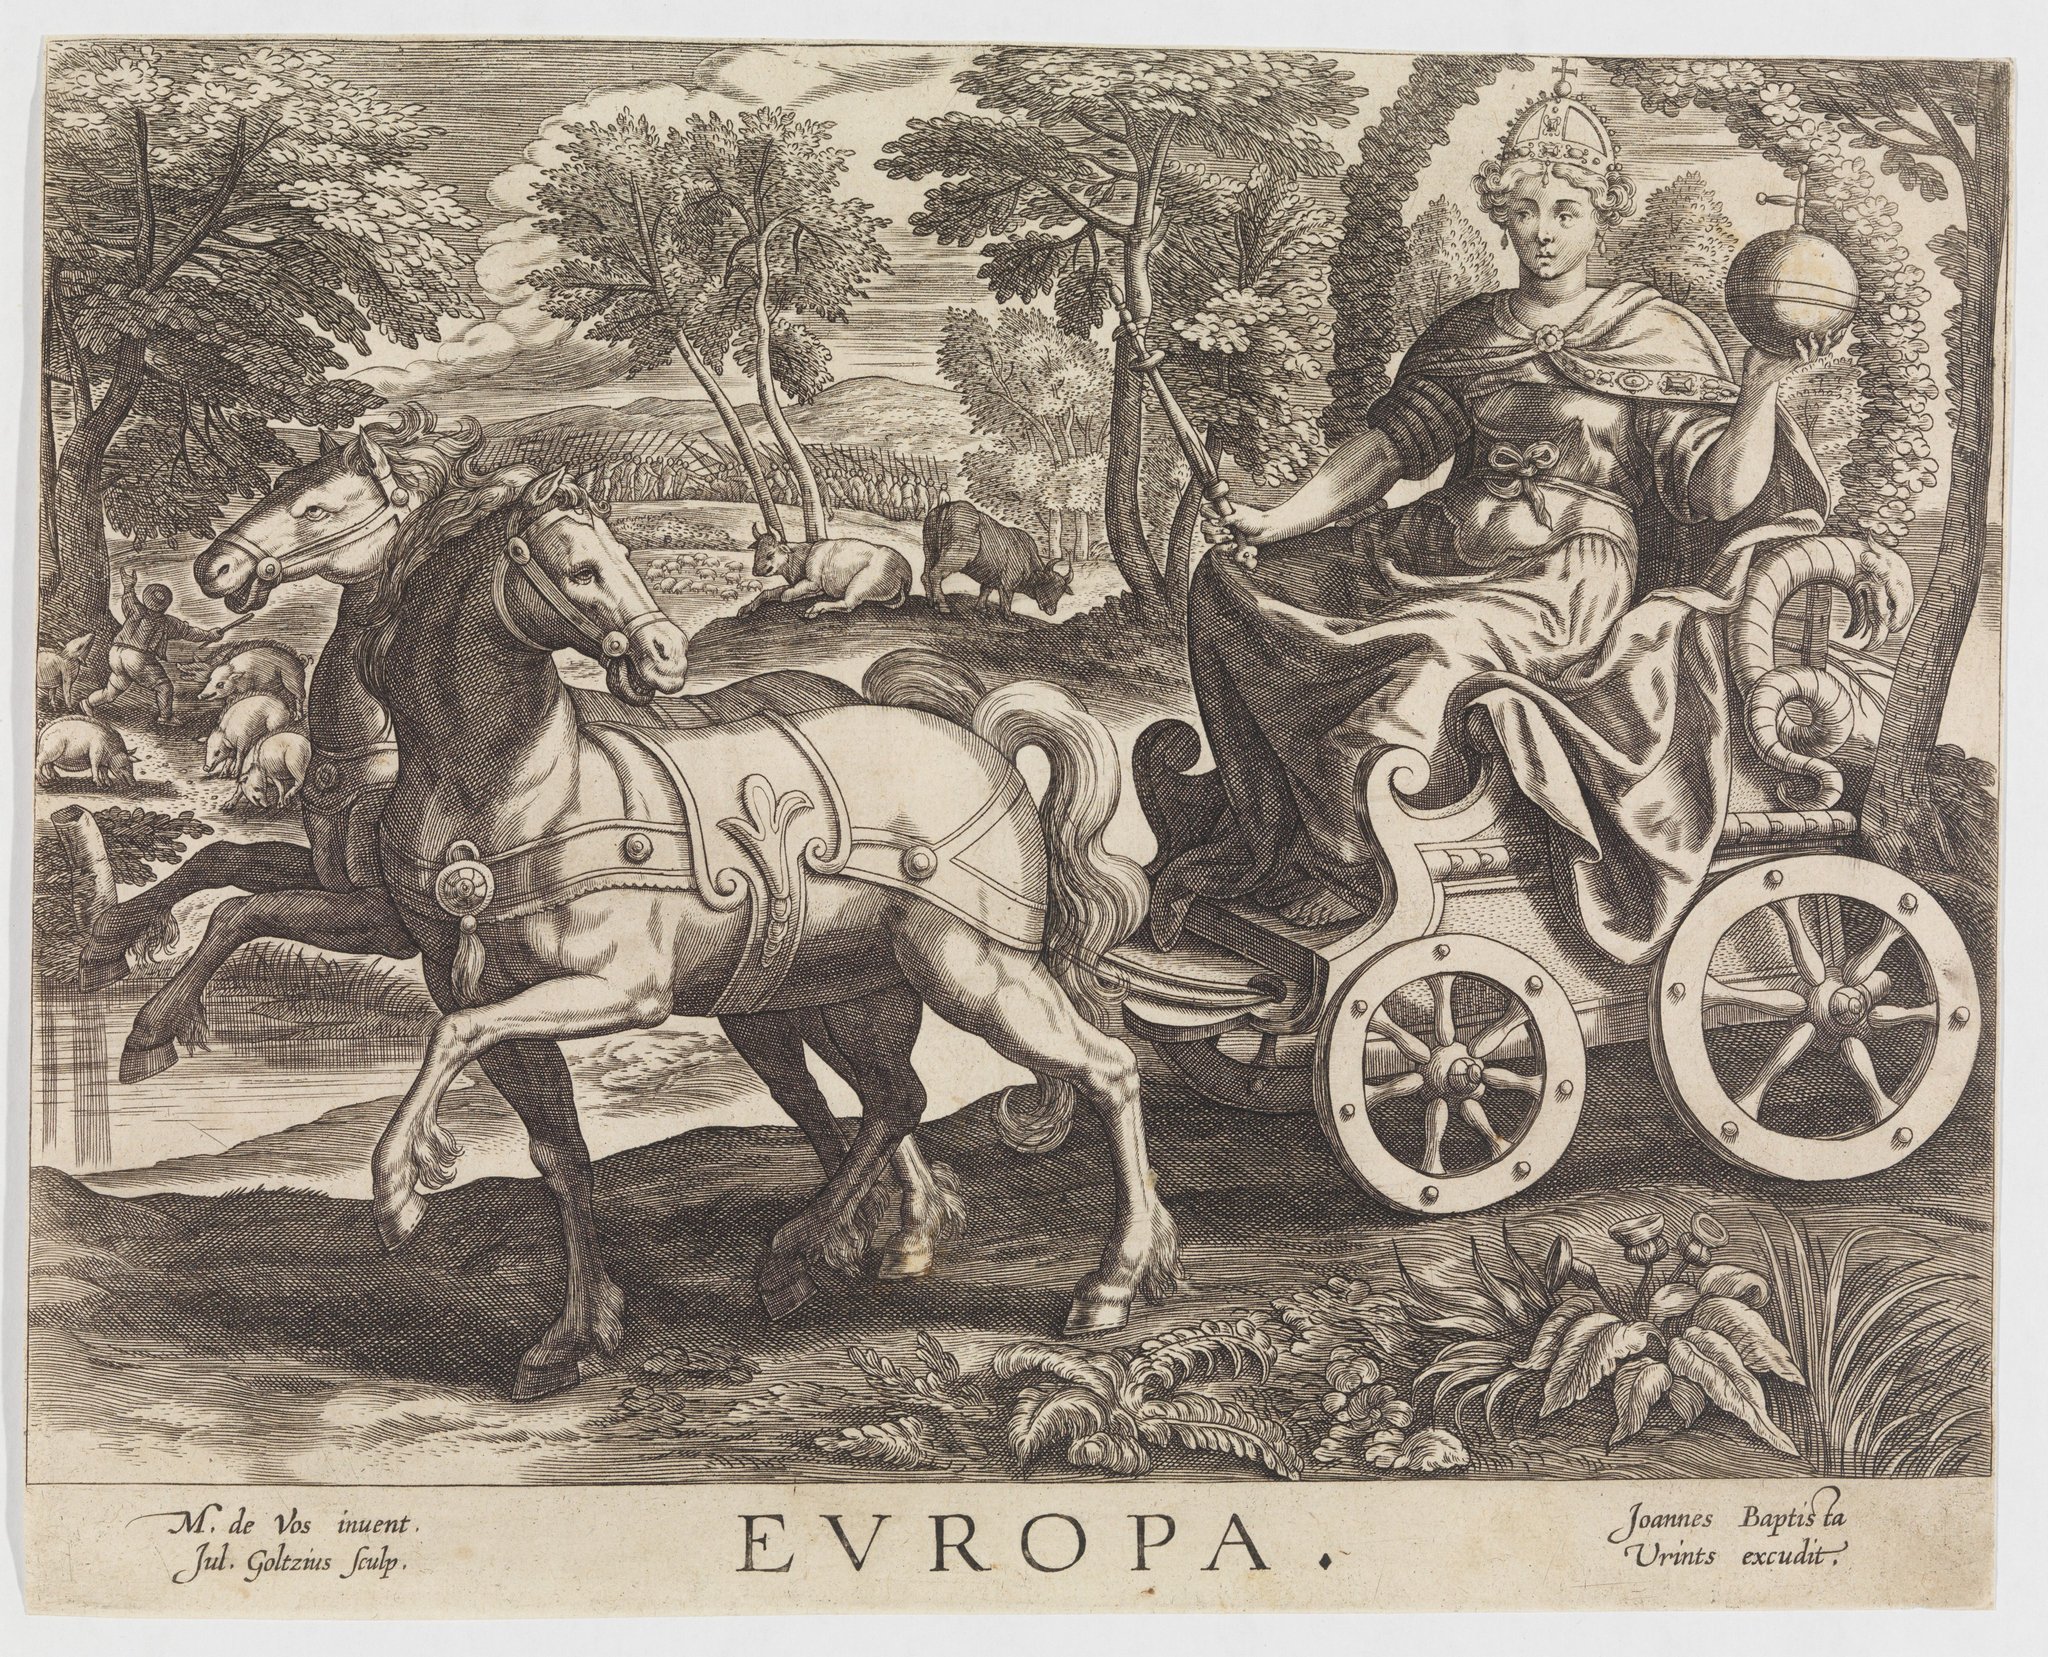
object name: print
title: Europa, from "The Four Continents"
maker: julius goltzius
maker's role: artist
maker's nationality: netherlandish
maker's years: 1500-1595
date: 1501-1600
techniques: engraving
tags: europa,horses,chariots